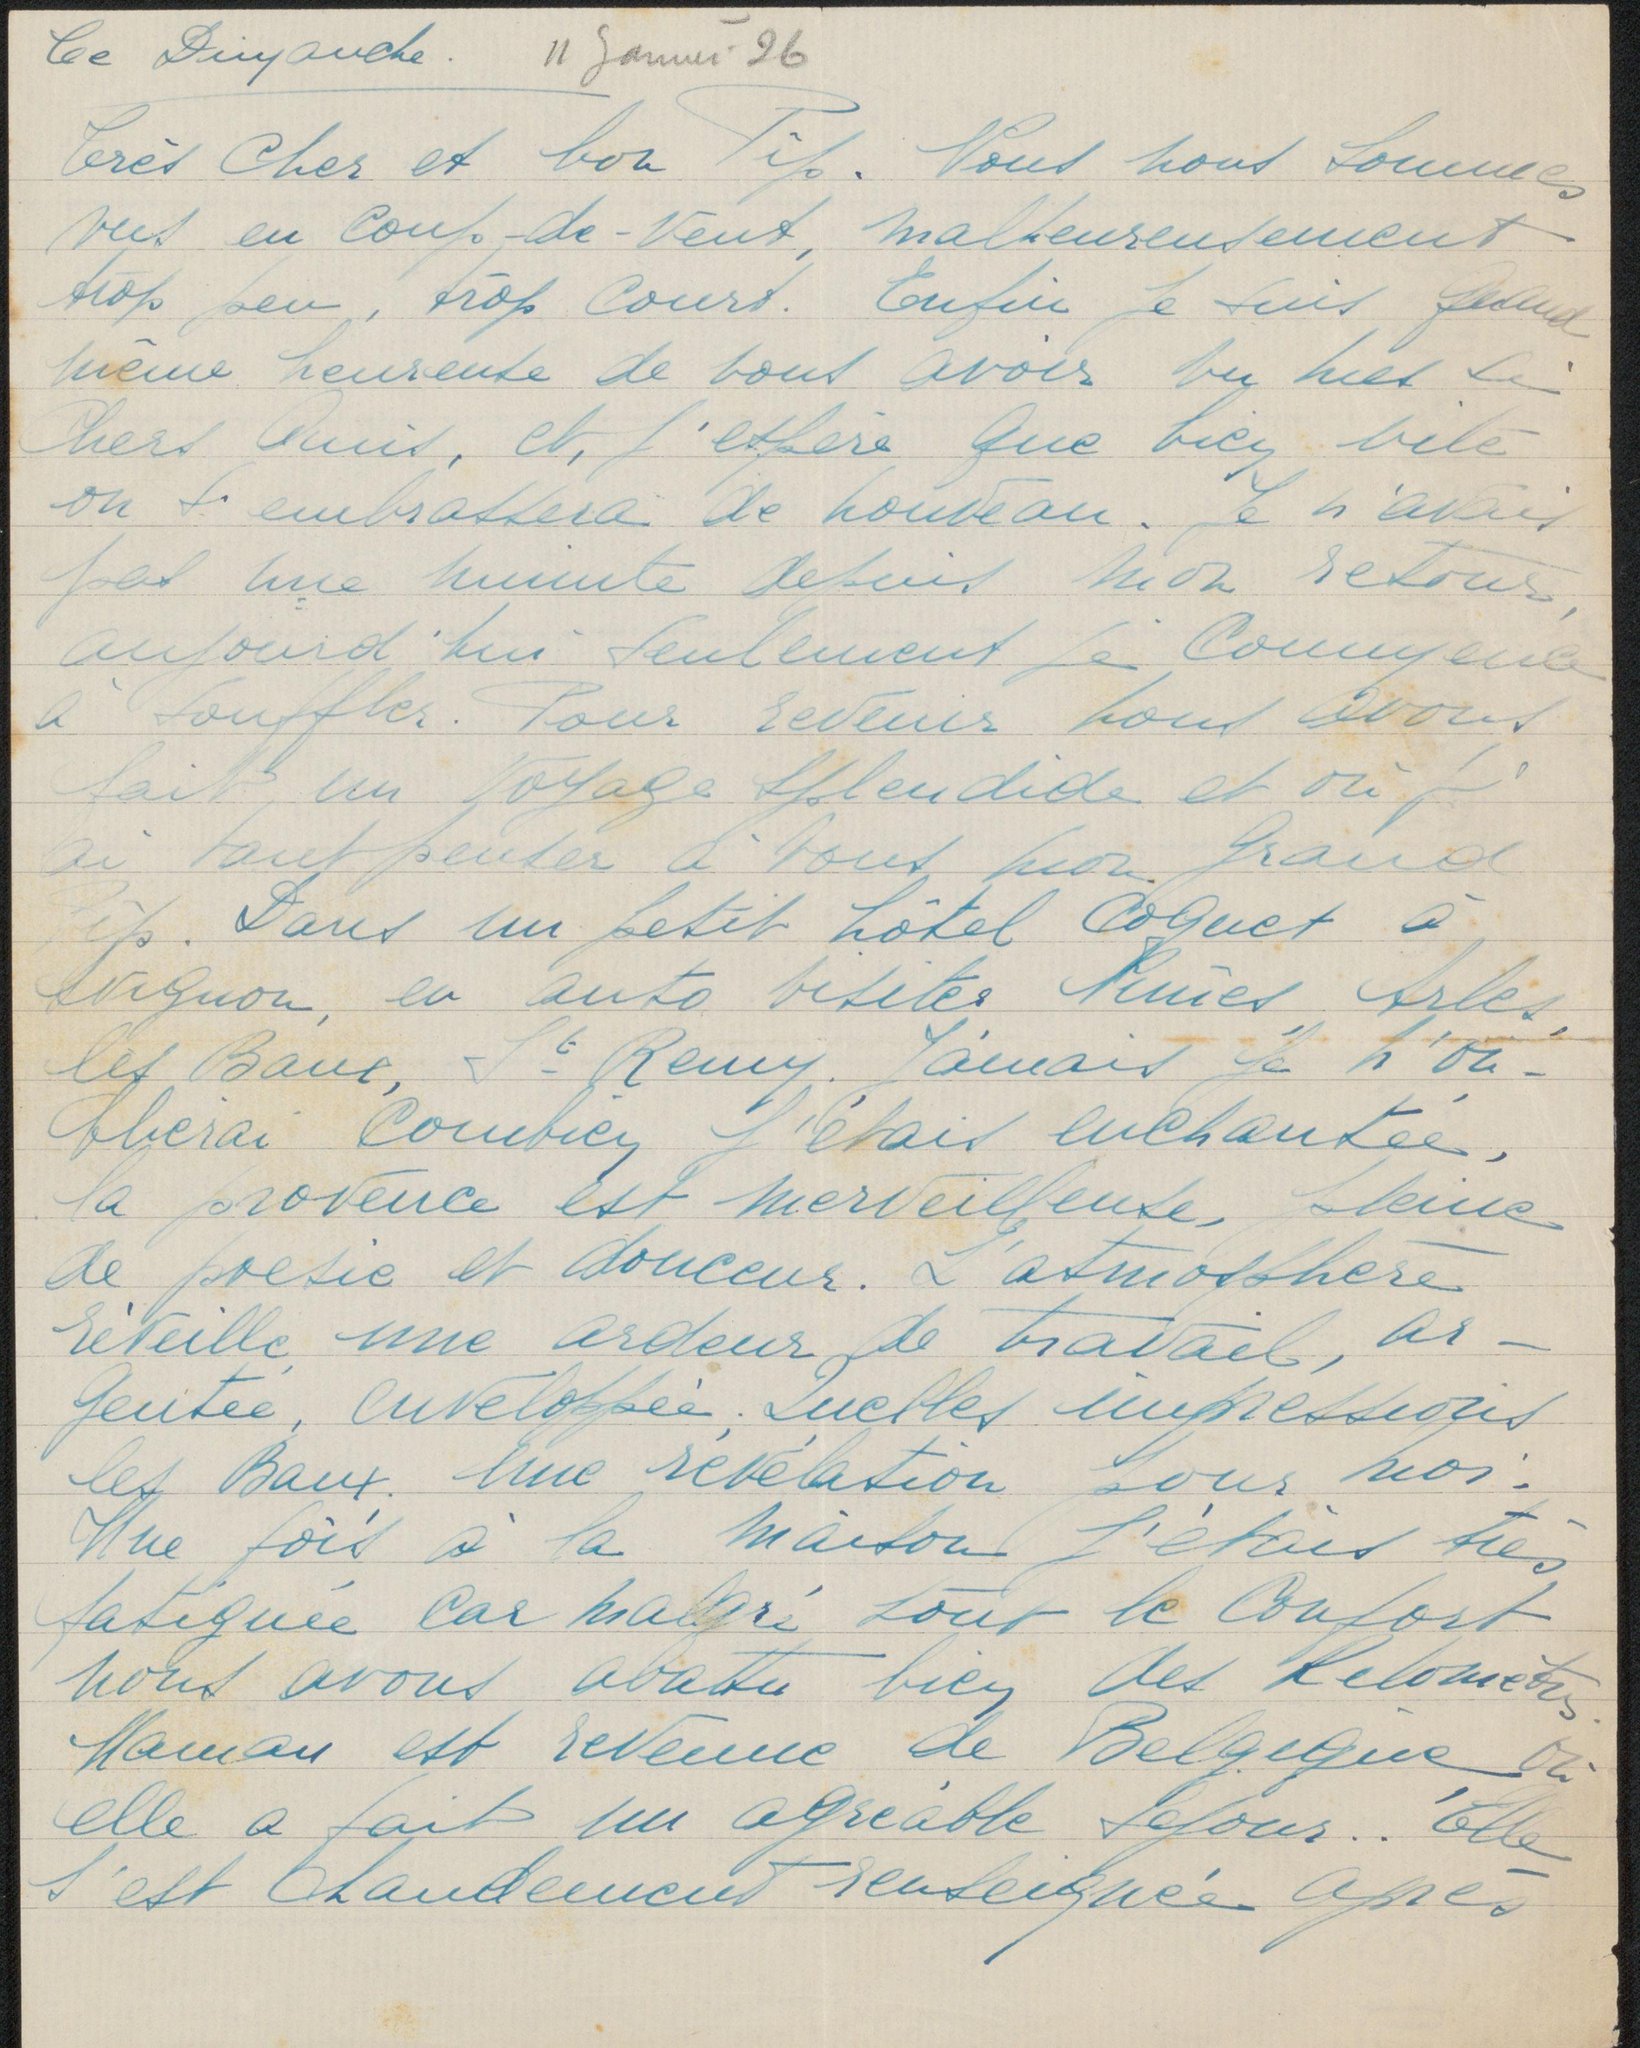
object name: letter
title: Brief aan Philip Zilcken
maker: rose imel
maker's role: draughtsman, painter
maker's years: 1901-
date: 1911-1930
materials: ink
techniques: pen, writing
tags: painter, draughtsman, philip zilcken, drawing, workshop, studio of the artist (in general)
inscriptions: collector's mark: ‘RPK’